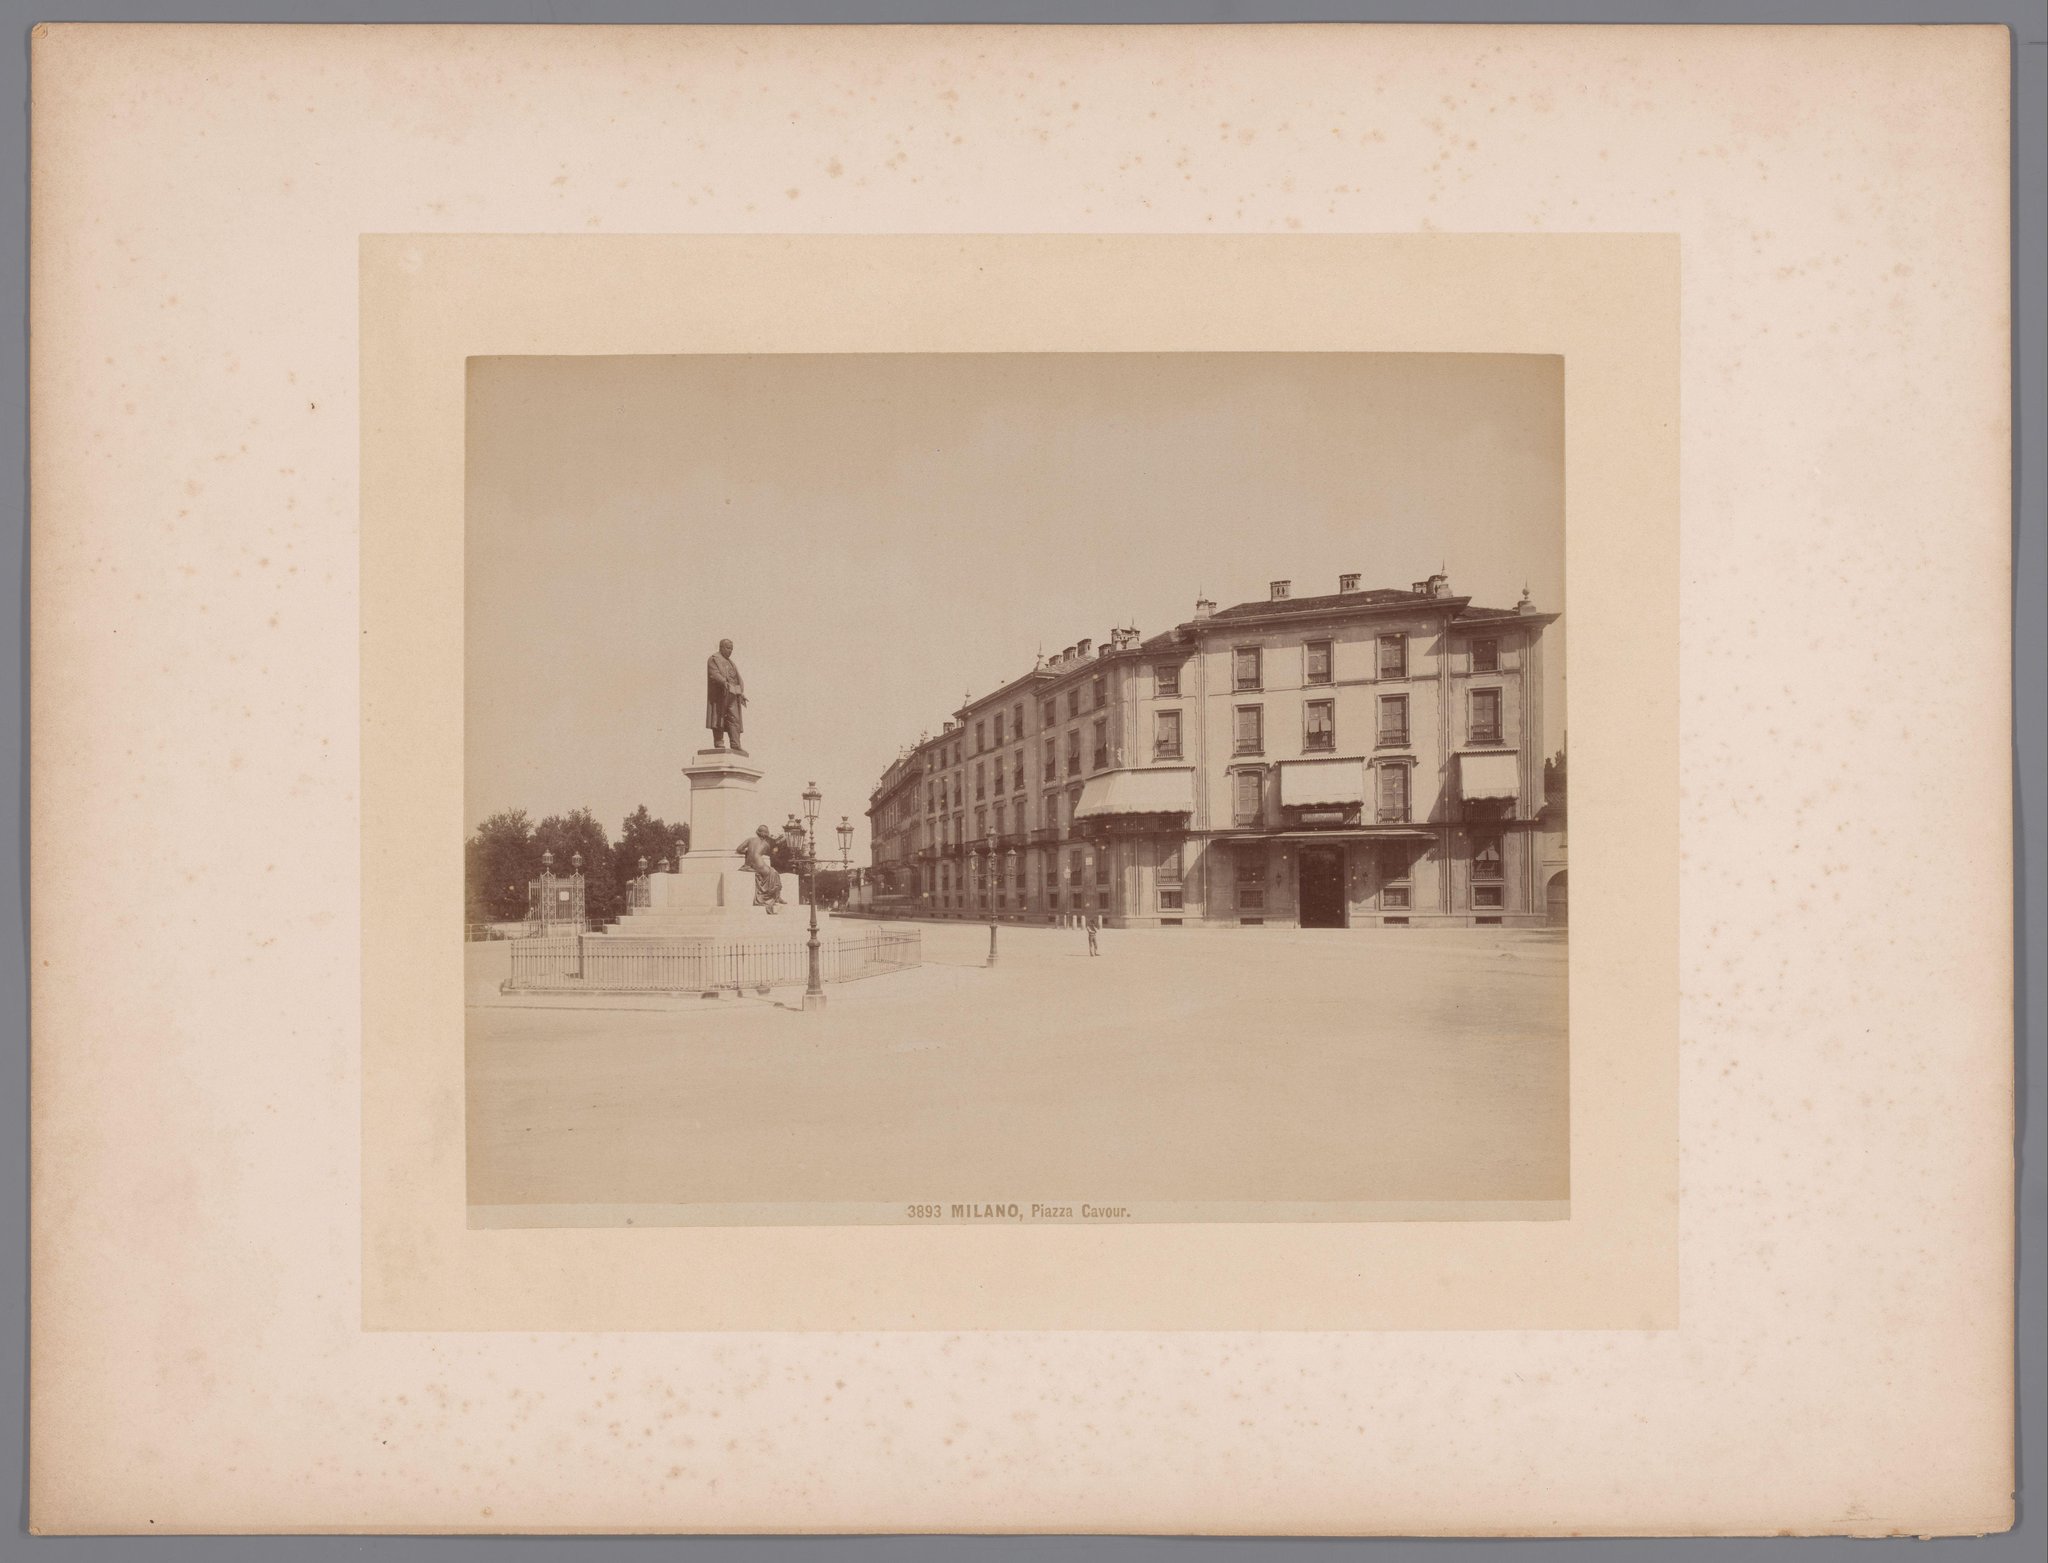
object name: photograph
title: Gezicht op het Piazza Cavour te Milaan, Italië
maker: giacomo brogi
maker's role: fotograaf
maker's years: 1822-1881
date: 1865-1881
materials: cardboard, paper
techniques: albumen print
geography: milan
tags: politician, square, place, circus, etc., monument, statue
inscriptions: number: ‘3893’, inscription: ‘Brogi (+)’